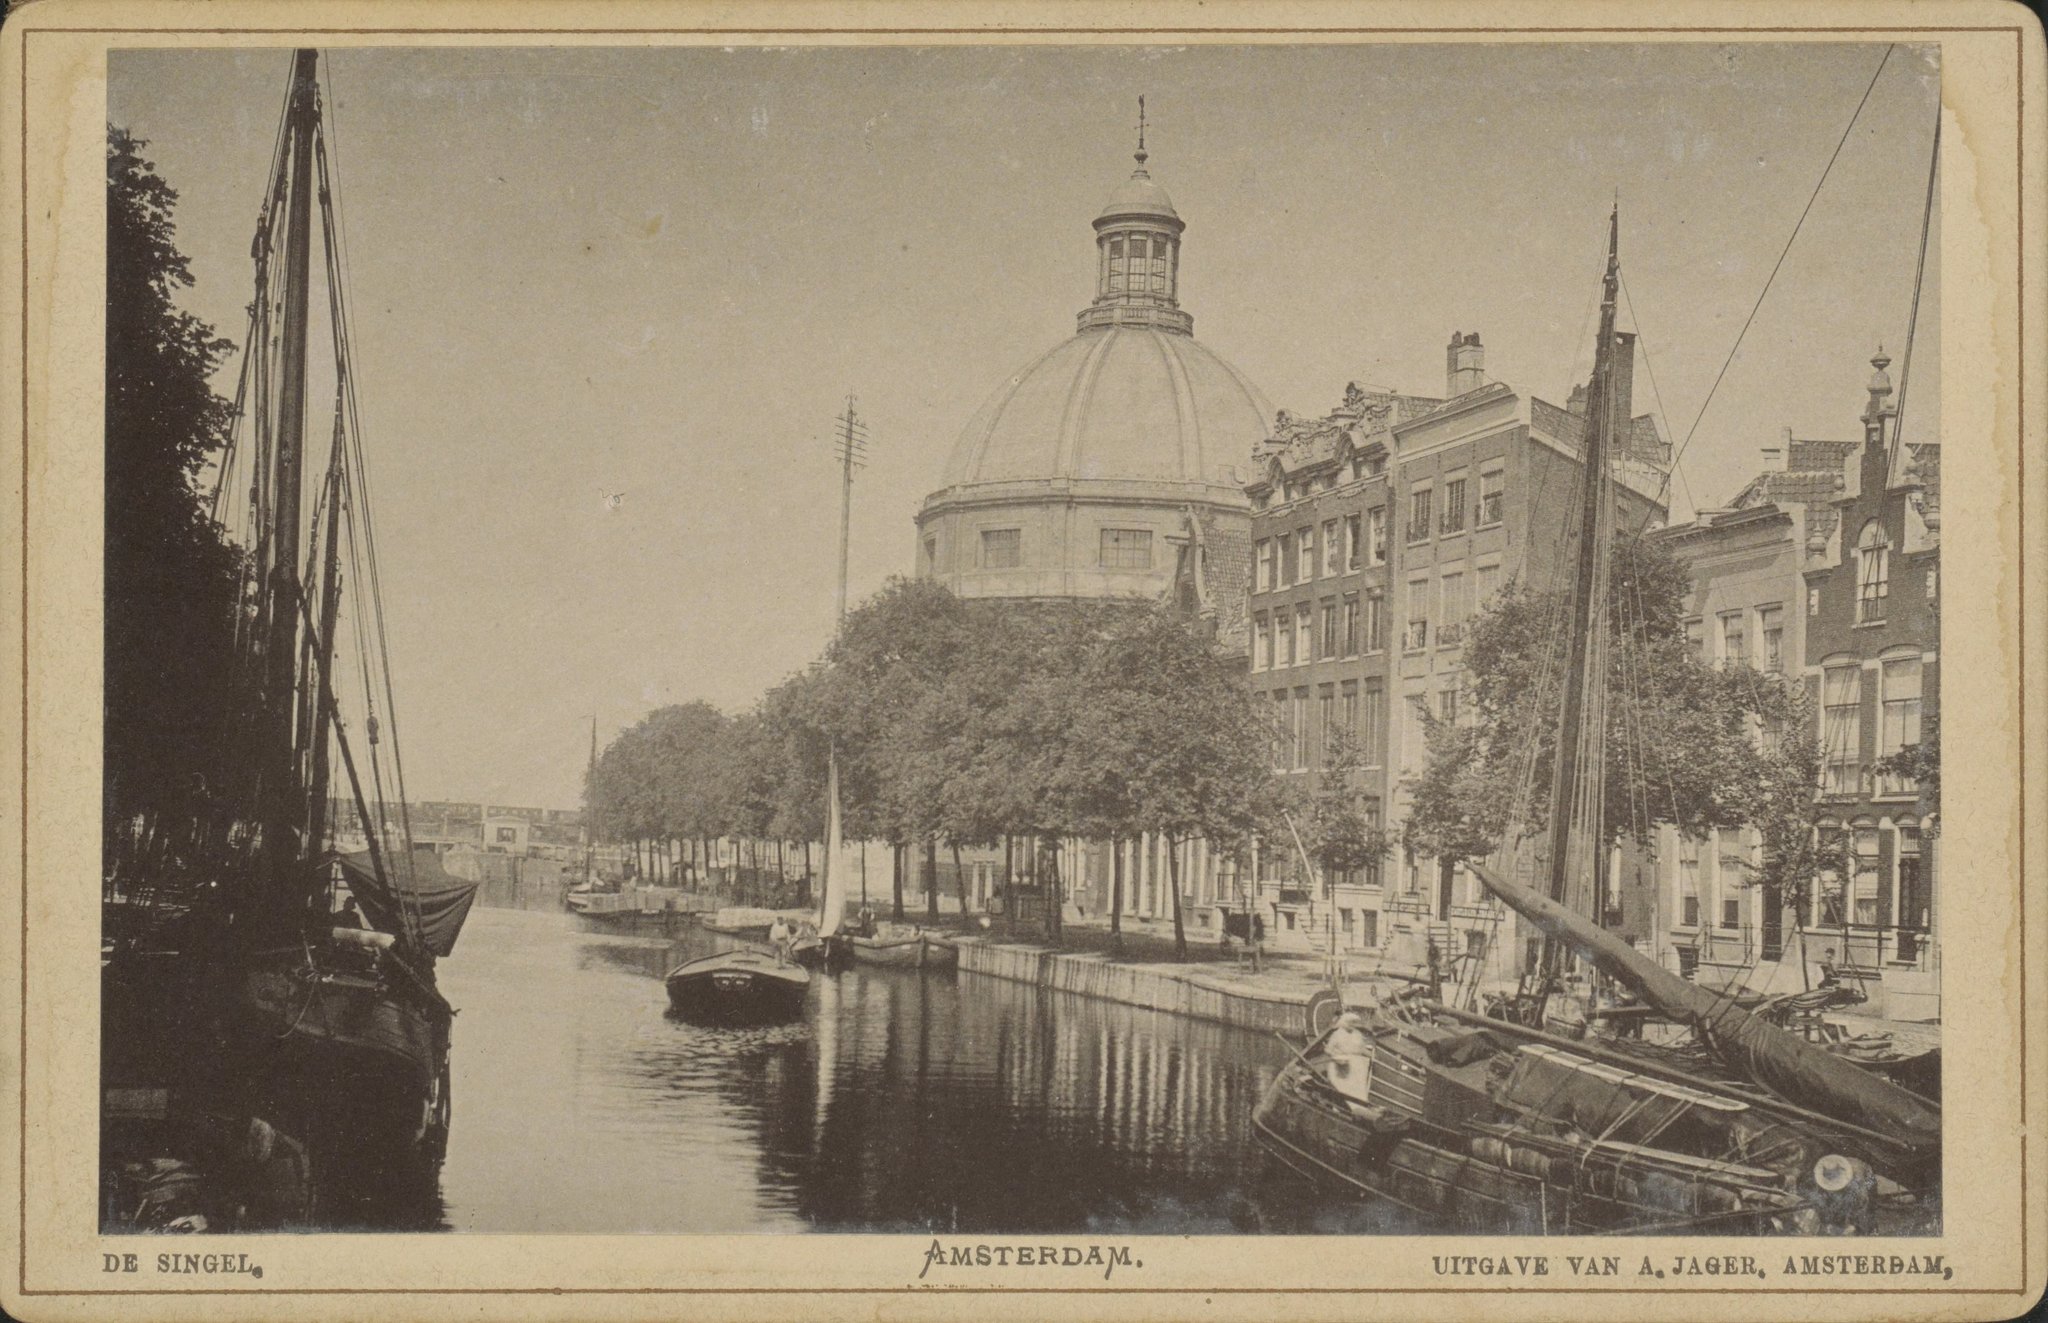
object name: photograph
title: Singel en Nieuwe of Ronde Lutherse Kerk, Amsterdam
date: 1880-1895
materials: cardboard, paper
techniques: photograph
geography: amsterdam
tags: singel, ronde lutherse kerk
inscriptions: inscription: ‘DE SINGEL. AMSTERDAM. UITGAVE VAN A. JAGER, AMSTERDAM,’